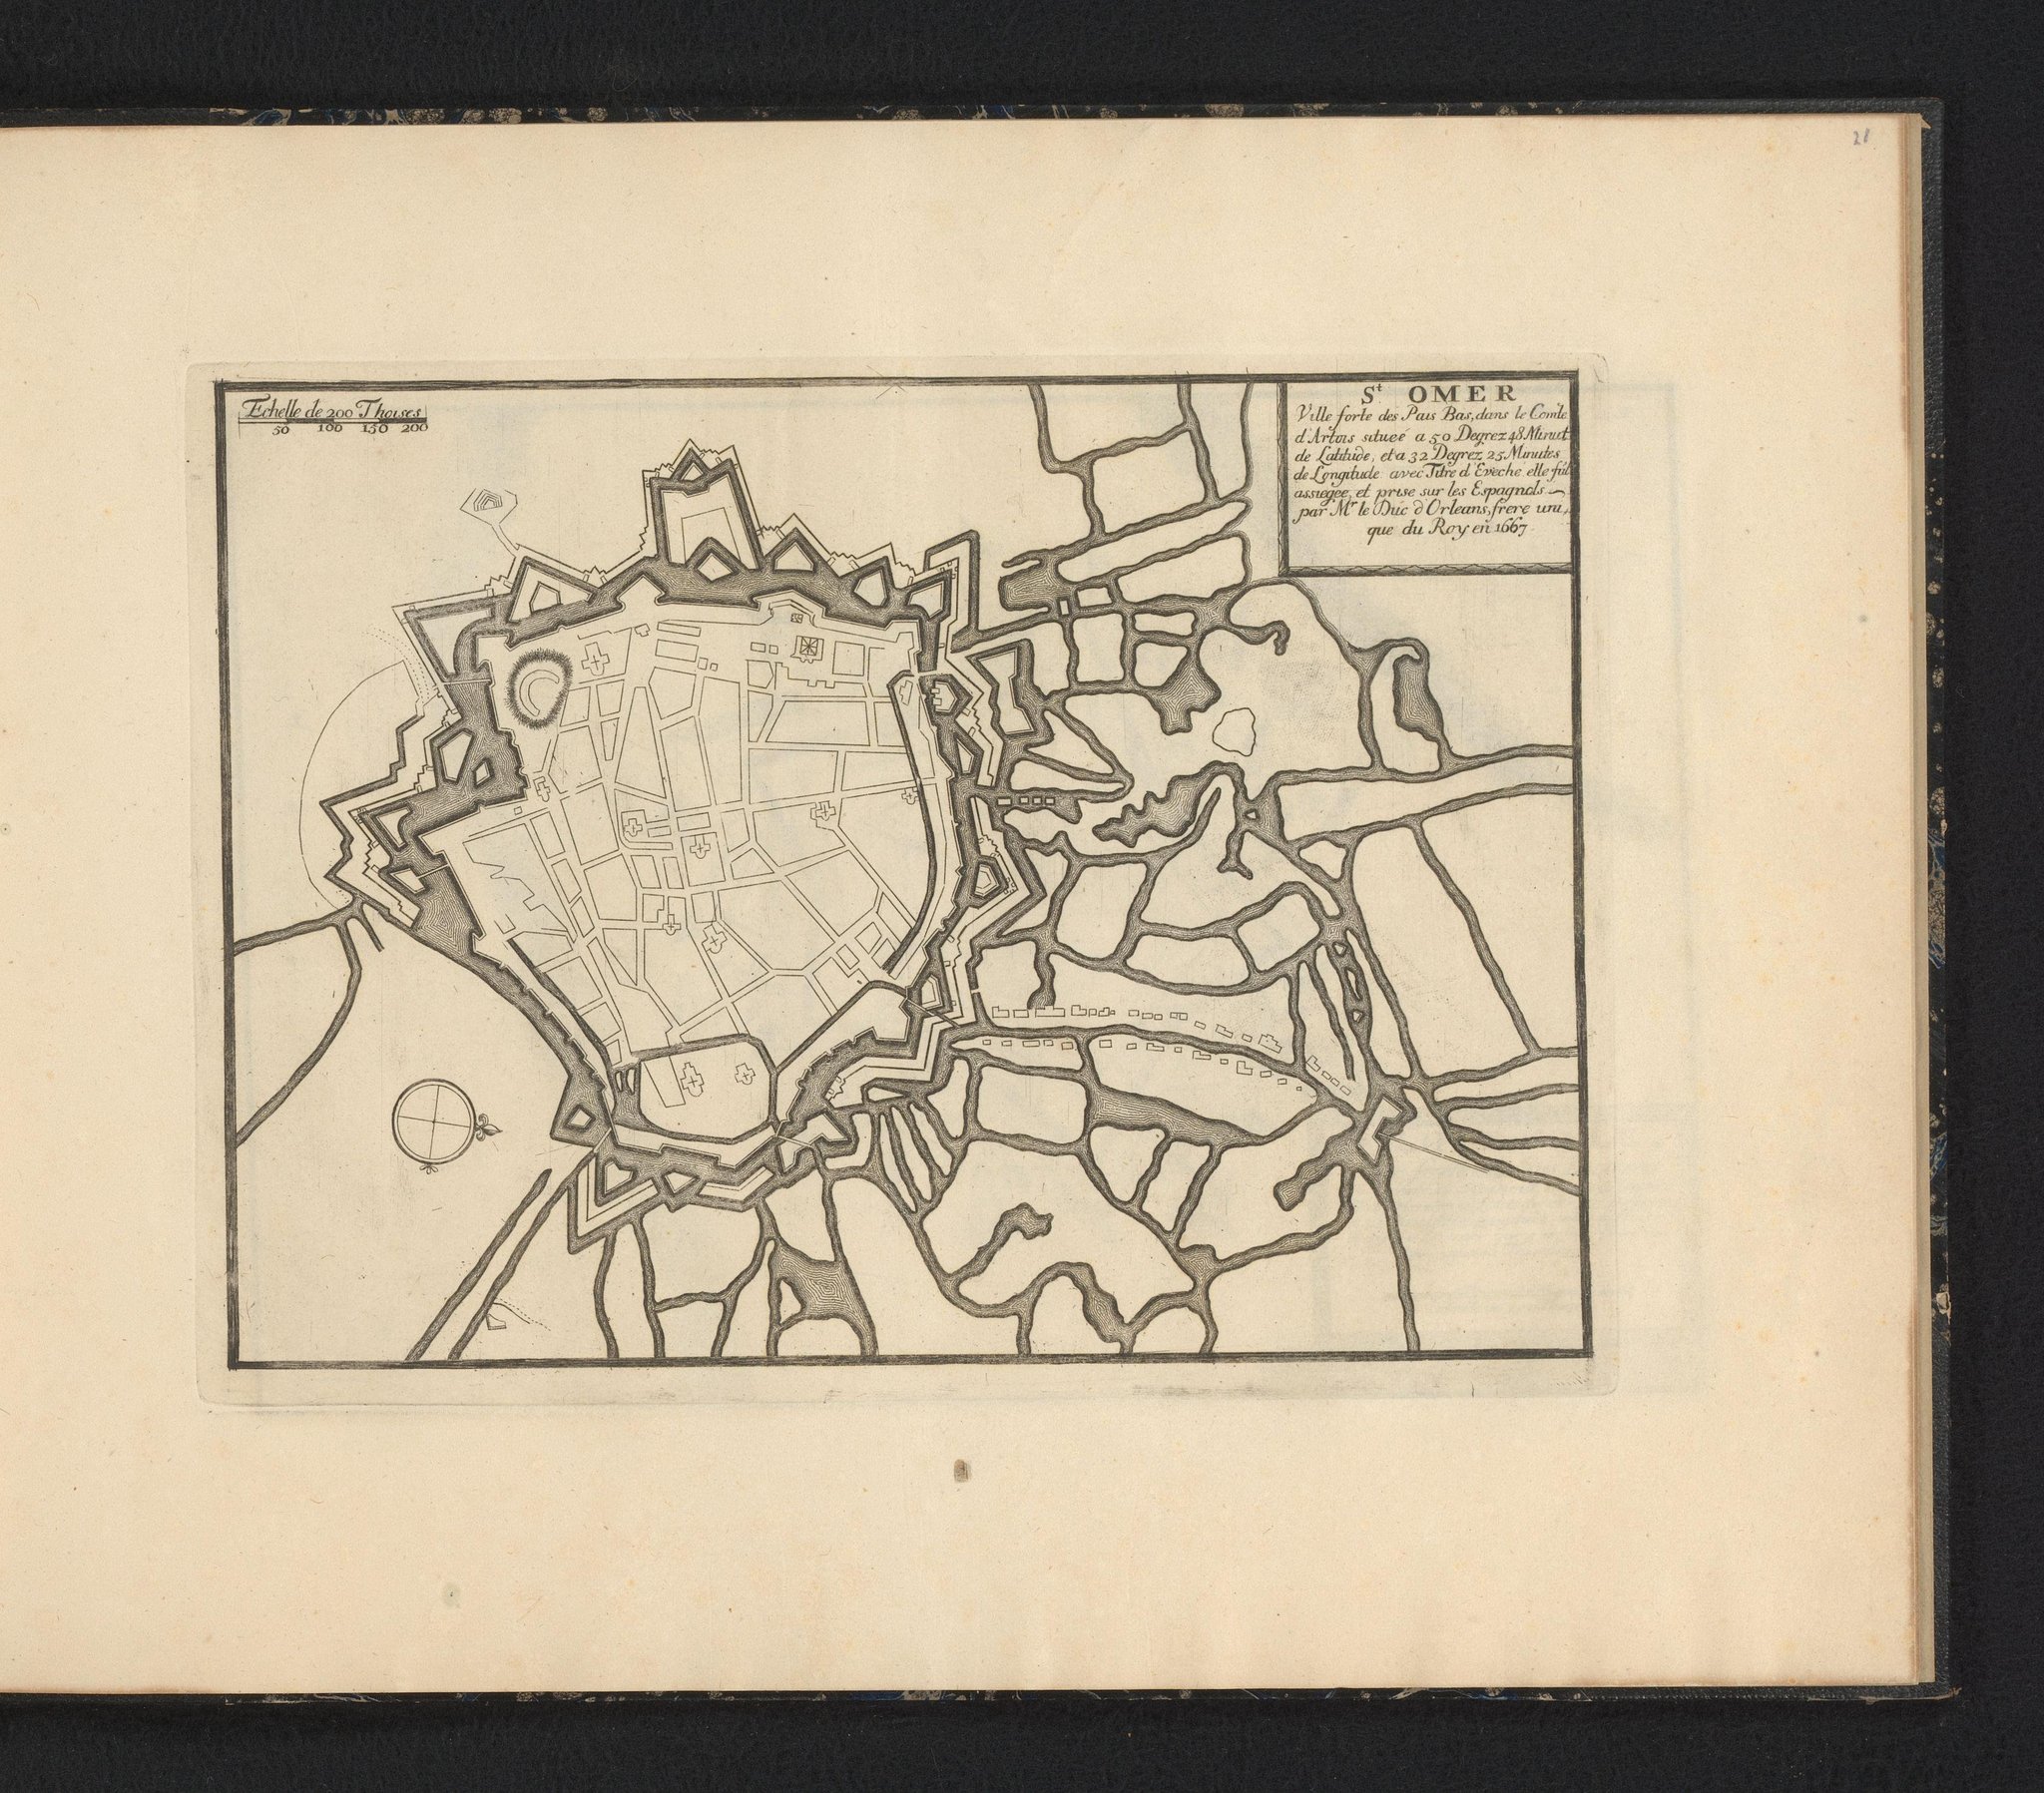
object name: print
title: Le theatre de la guerre, dans les Pays-Bas, ou representation des principales villes qui sont en Flandres, Hainaut, Brabant &c. Avec leurs fortifications (...) premier volume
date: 1693-1696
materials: paper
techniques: etching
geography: france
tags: fortress, maps of cities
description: Plattegrond van de versterkingen om de stad Saint-Omer in Artois. Maakt deel uit van het eerste deel van het prentwerk: Le Theatre de la Guerre, dans les Pays-Bas, uitgegeven in 1696. Dit deel bevat 25 platen met plannen (afkomstig van Sébastien Le Prestre, Seigneur de Vauban) van vermaarde sterke steden en vestingen in de Negenjarige Oorlog in de Nederlanden. Titel en opschriften in het Frans.